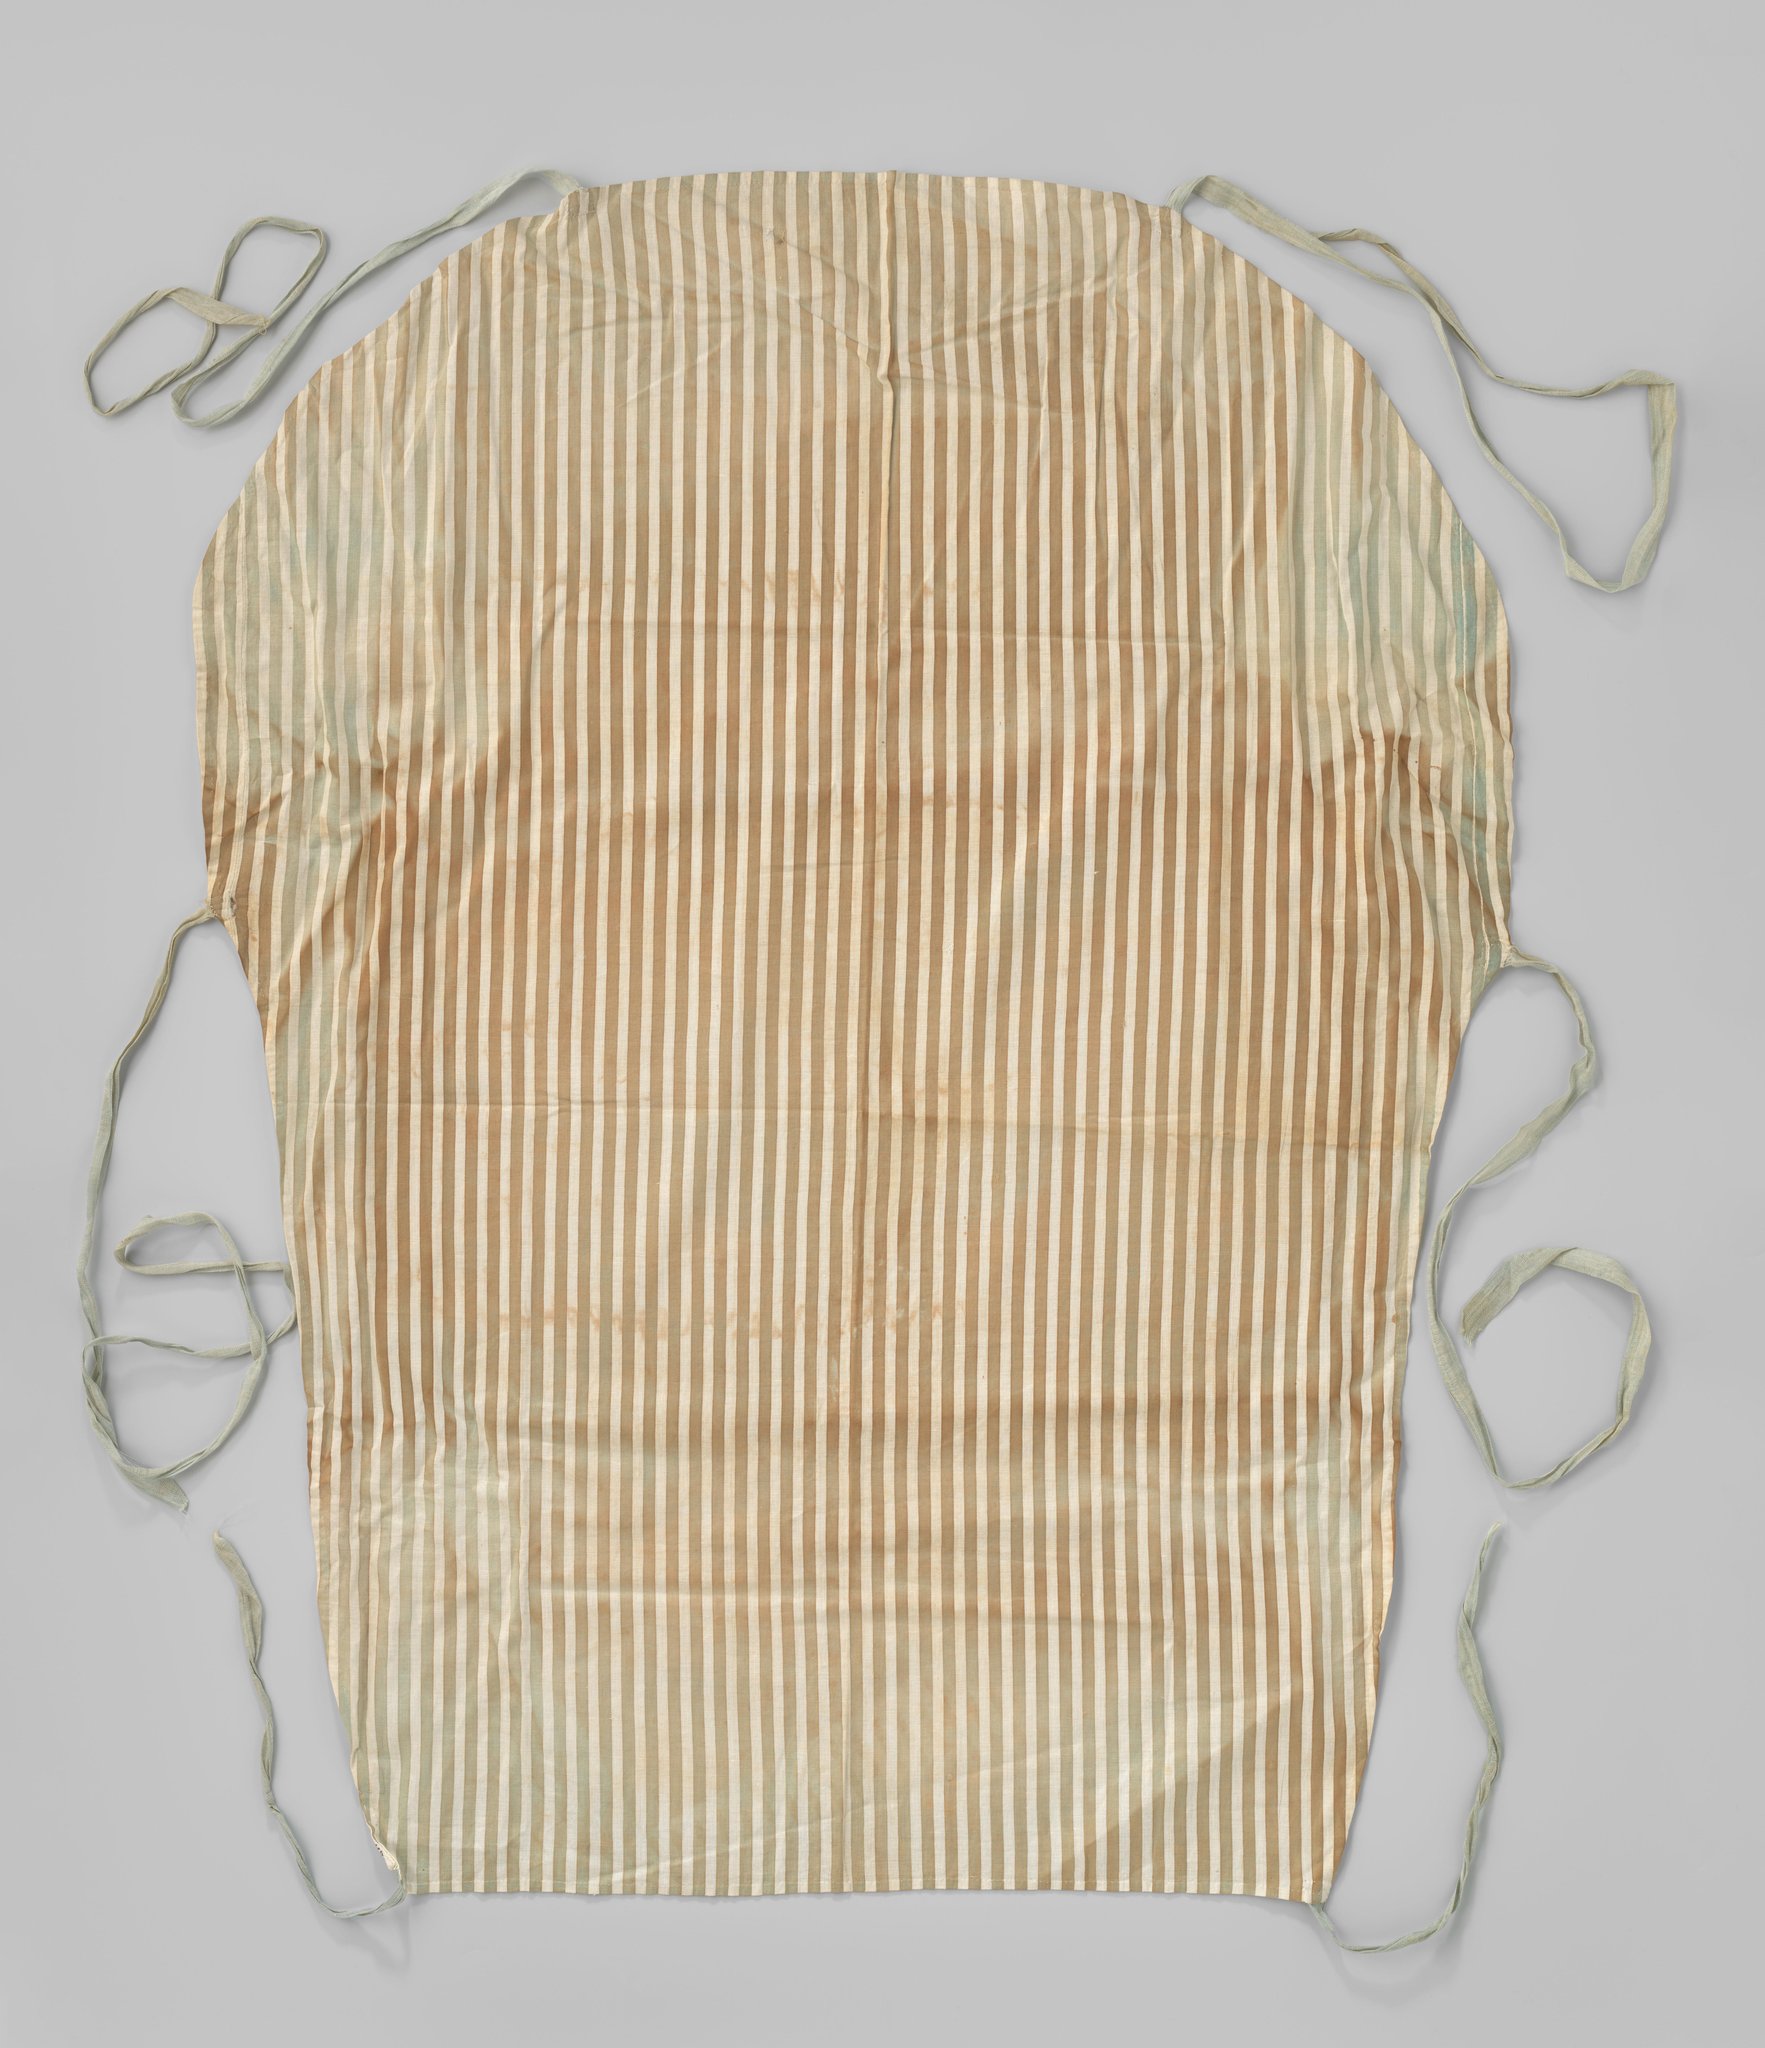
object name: poppengoed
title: Kussenovertrek (?) van groen wit gestreept katoen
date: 1836-1898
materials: textile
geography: netherlands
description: Kussenovertrek (?) van groen wit gestreept katoen; het sluit door middel van linten.